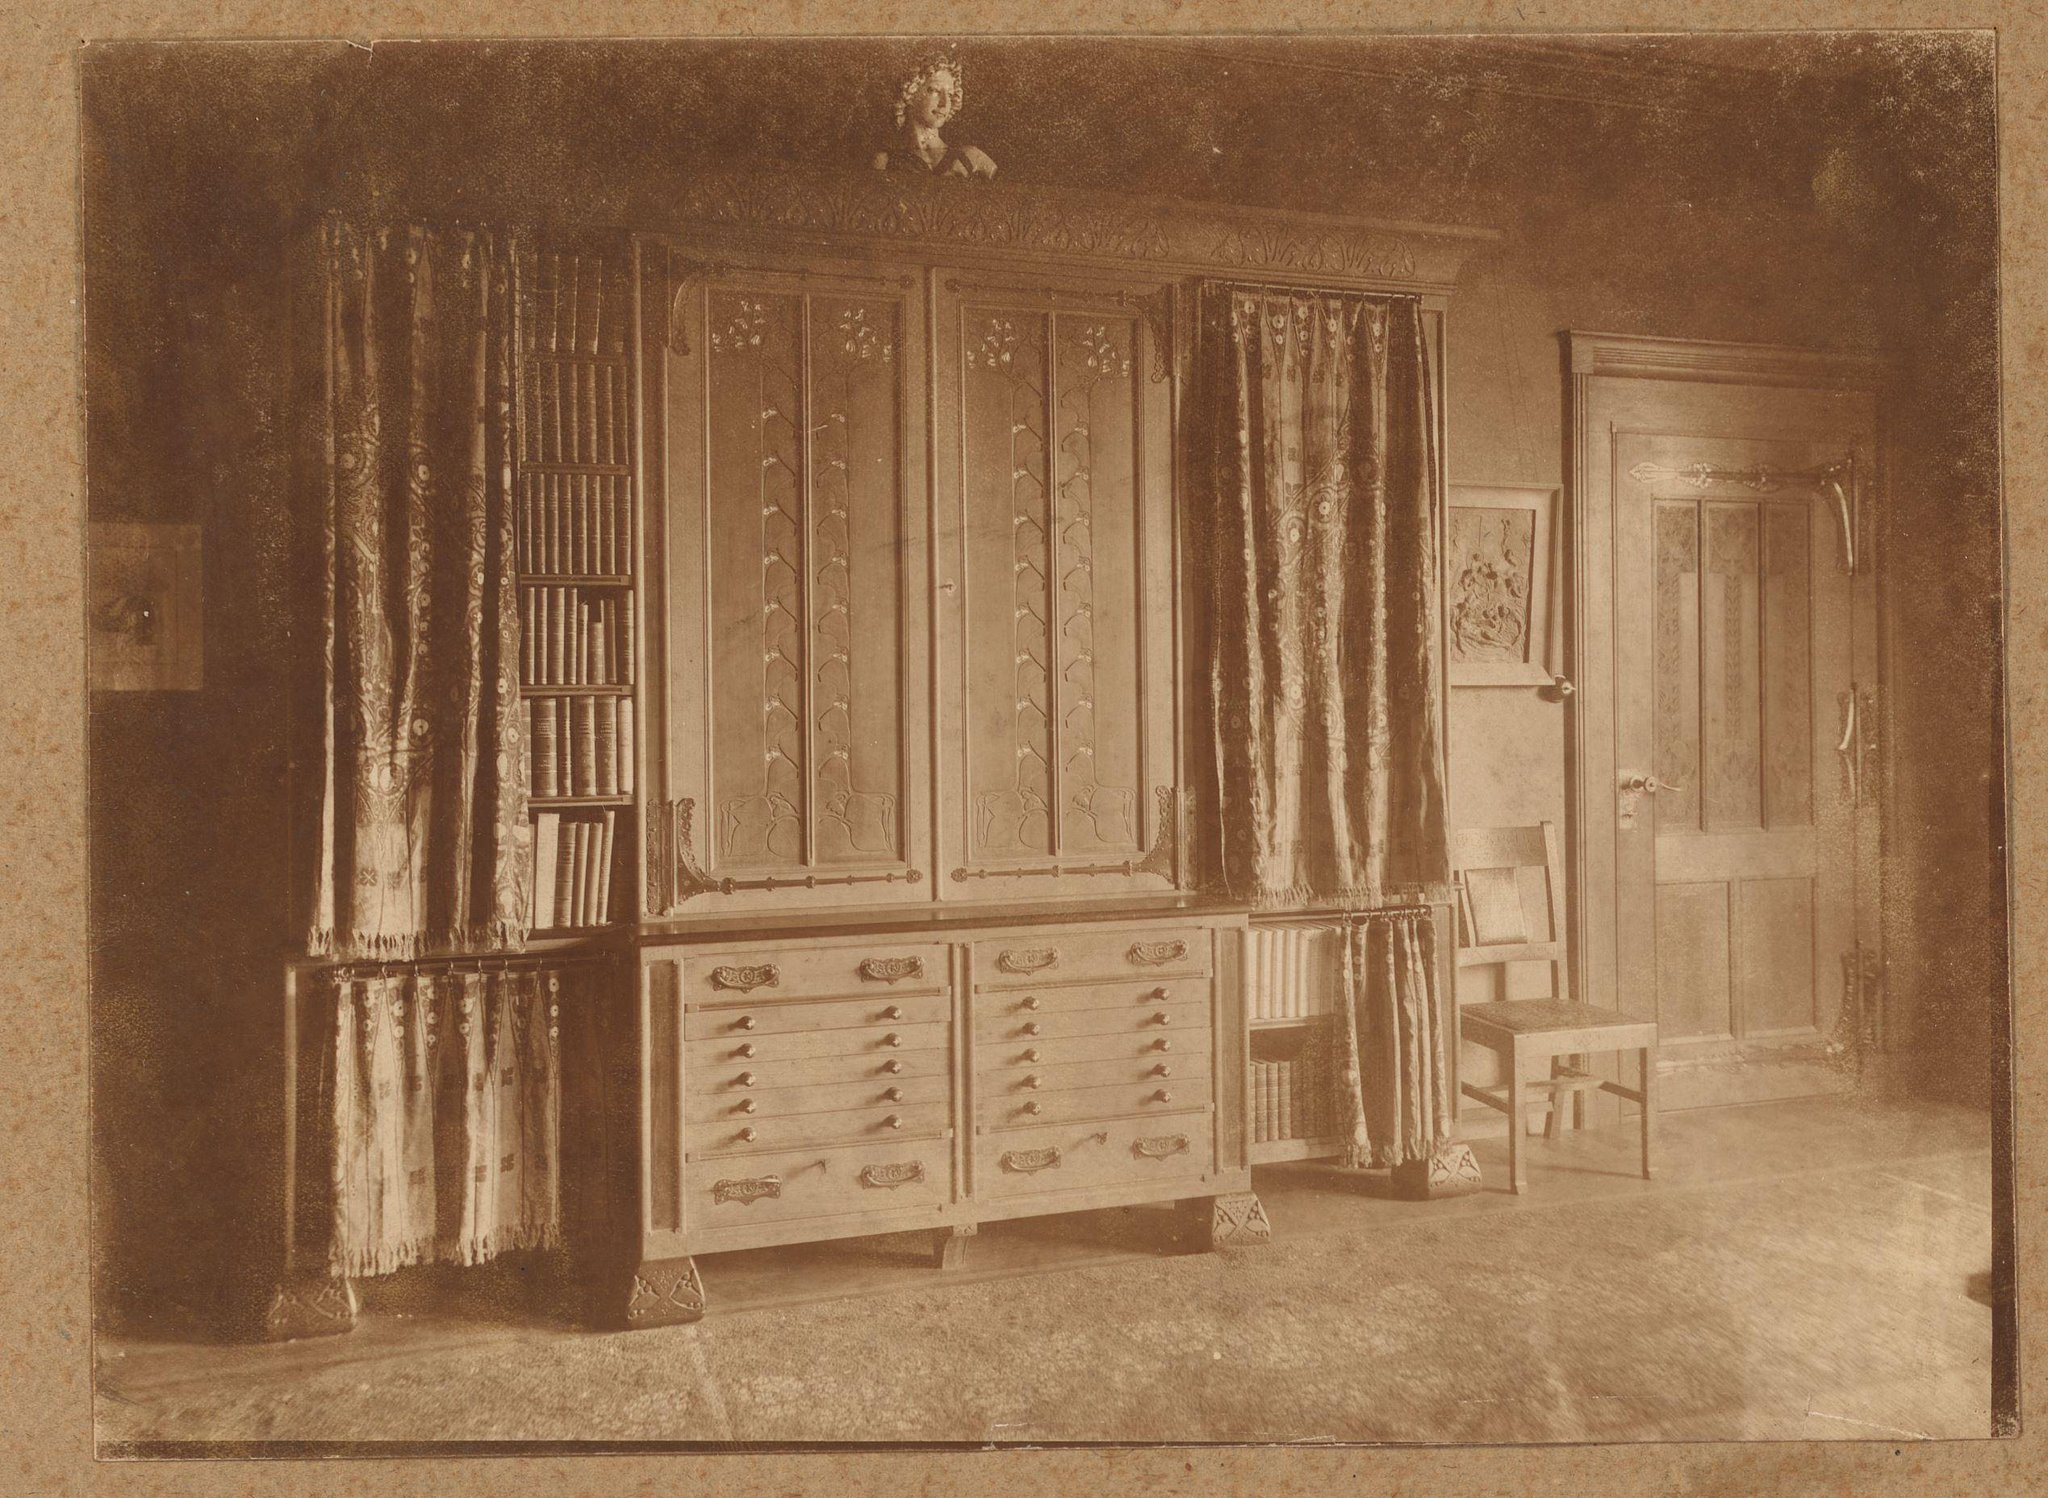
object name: photograph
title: Studeerkamer - eikenhout. Ontwerp van T. Nieuwenhuis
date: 1899-1902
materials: paper, cardboard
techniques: gelatin silver print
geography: netherlands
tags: print maker, draughtsman, theo nieuwenhuis, furniture for storage, amsterdam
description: Dossierkast in de studeerkamer in het huis van mr. Ferdinand Kranenburg te Amsterdam, ontworpen door Theo Nieuwenhuis in de werkplaats van E.J. van Wisselingh & Co., Amsterdam. Uit een serie van oorspronkelijk vijf foto's die samen op een karton geplakt zijn.